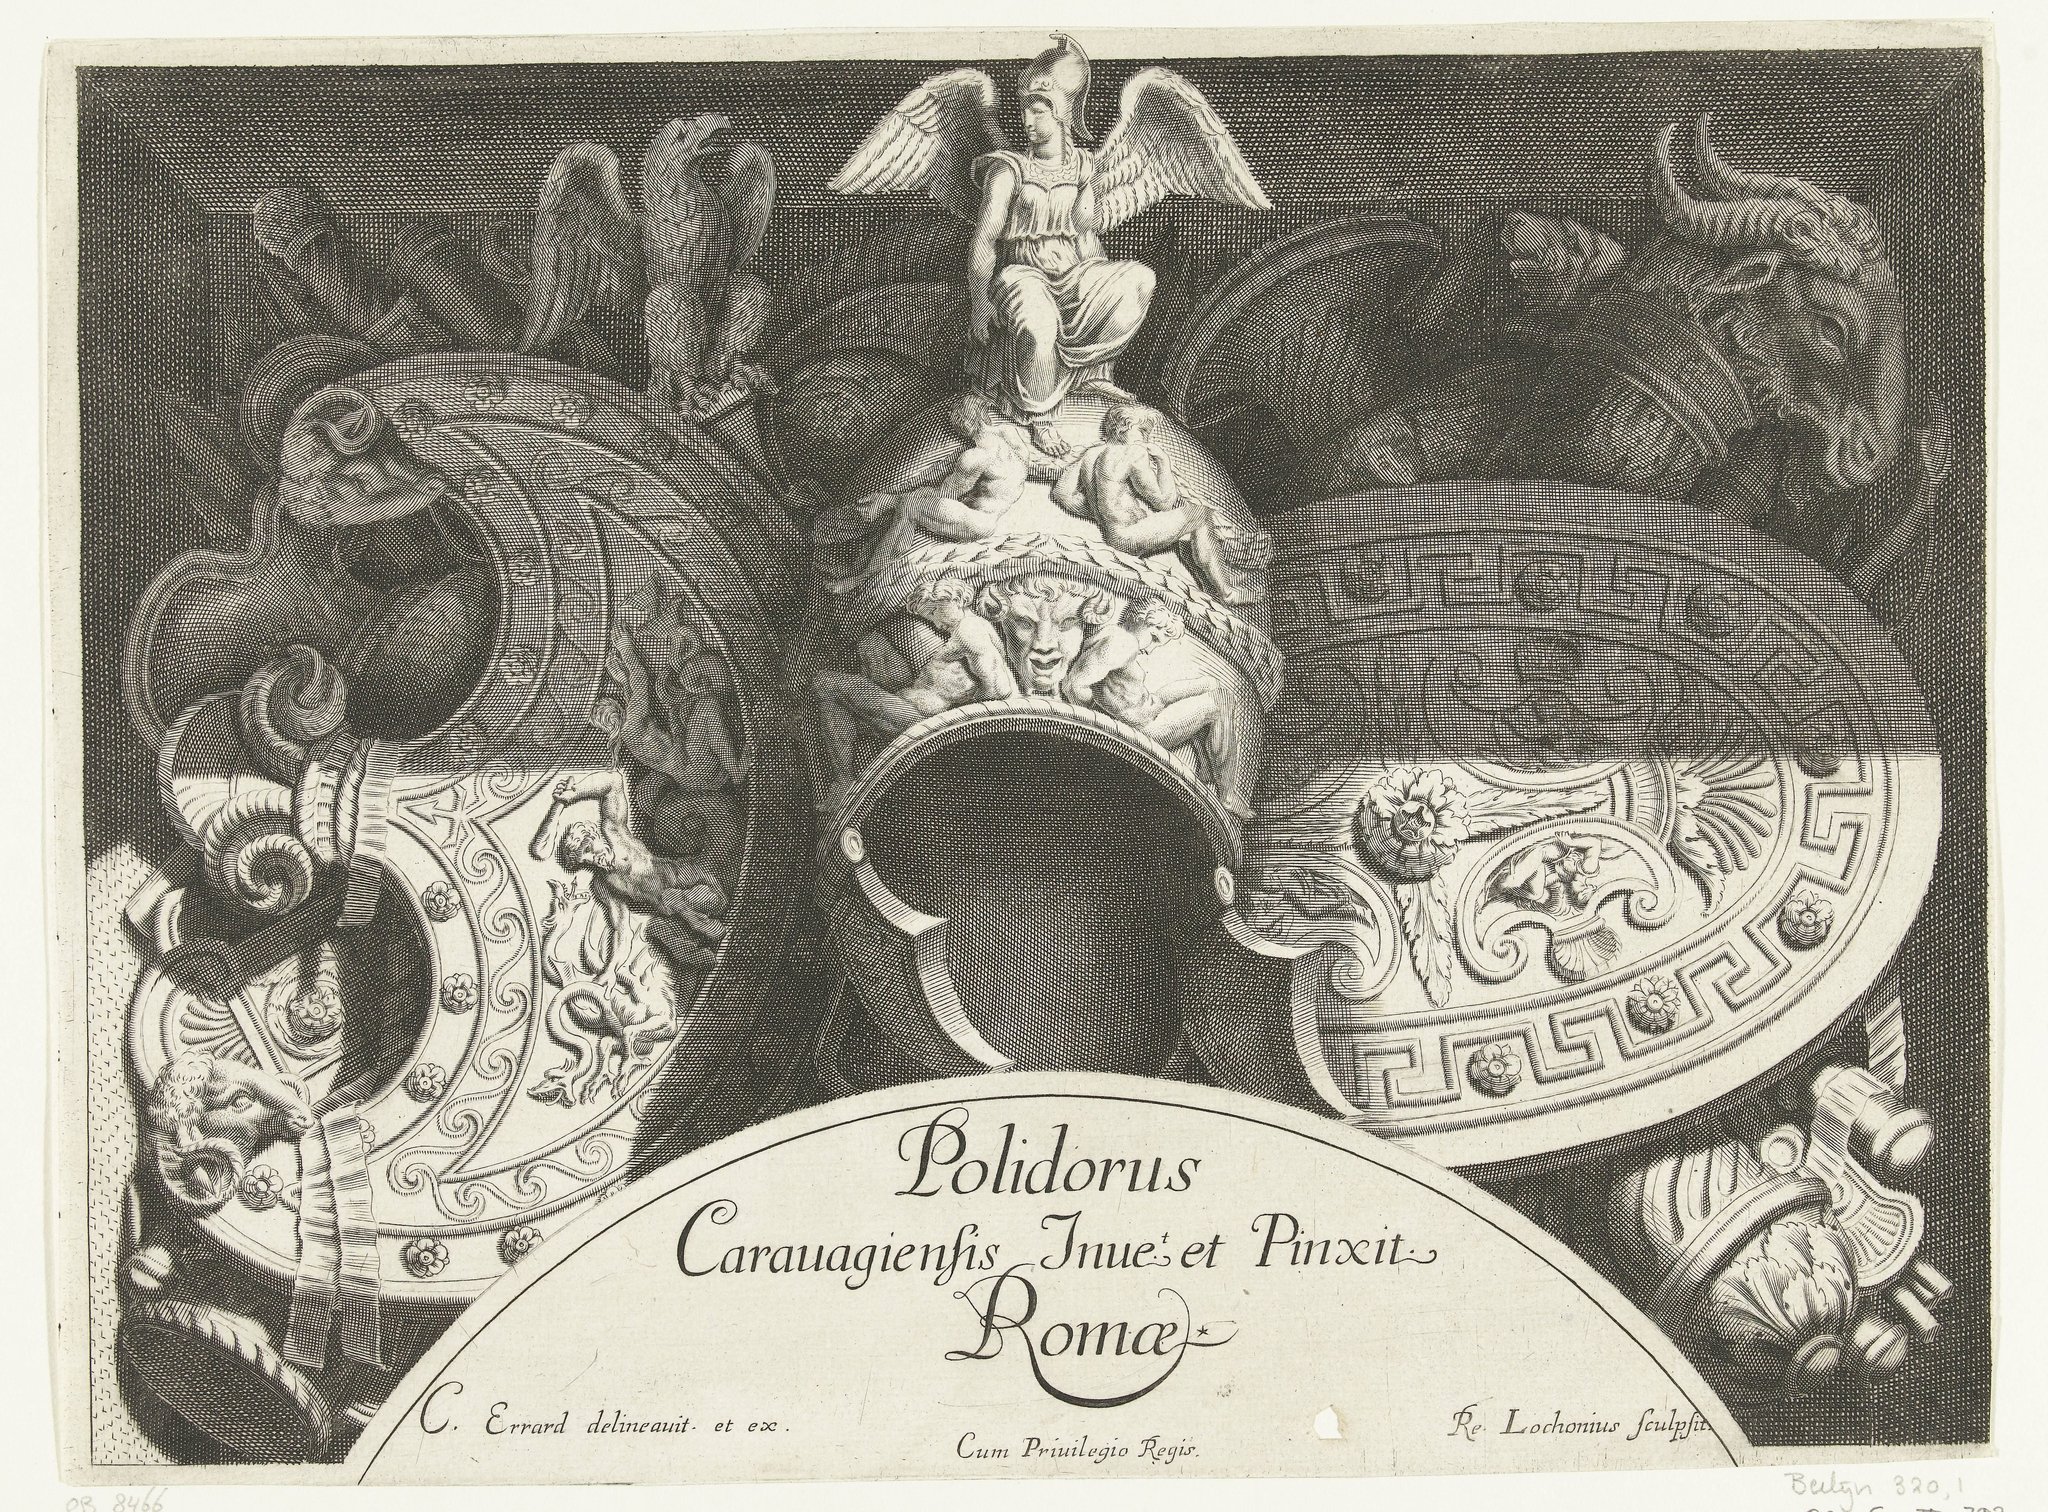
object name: ornament print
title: Divers Trophées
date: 1651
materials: paper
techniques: engraving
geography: france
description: Nike heeft twee gevangenen aan haar voeten. Uit serie van titelblad en vijf bladen.